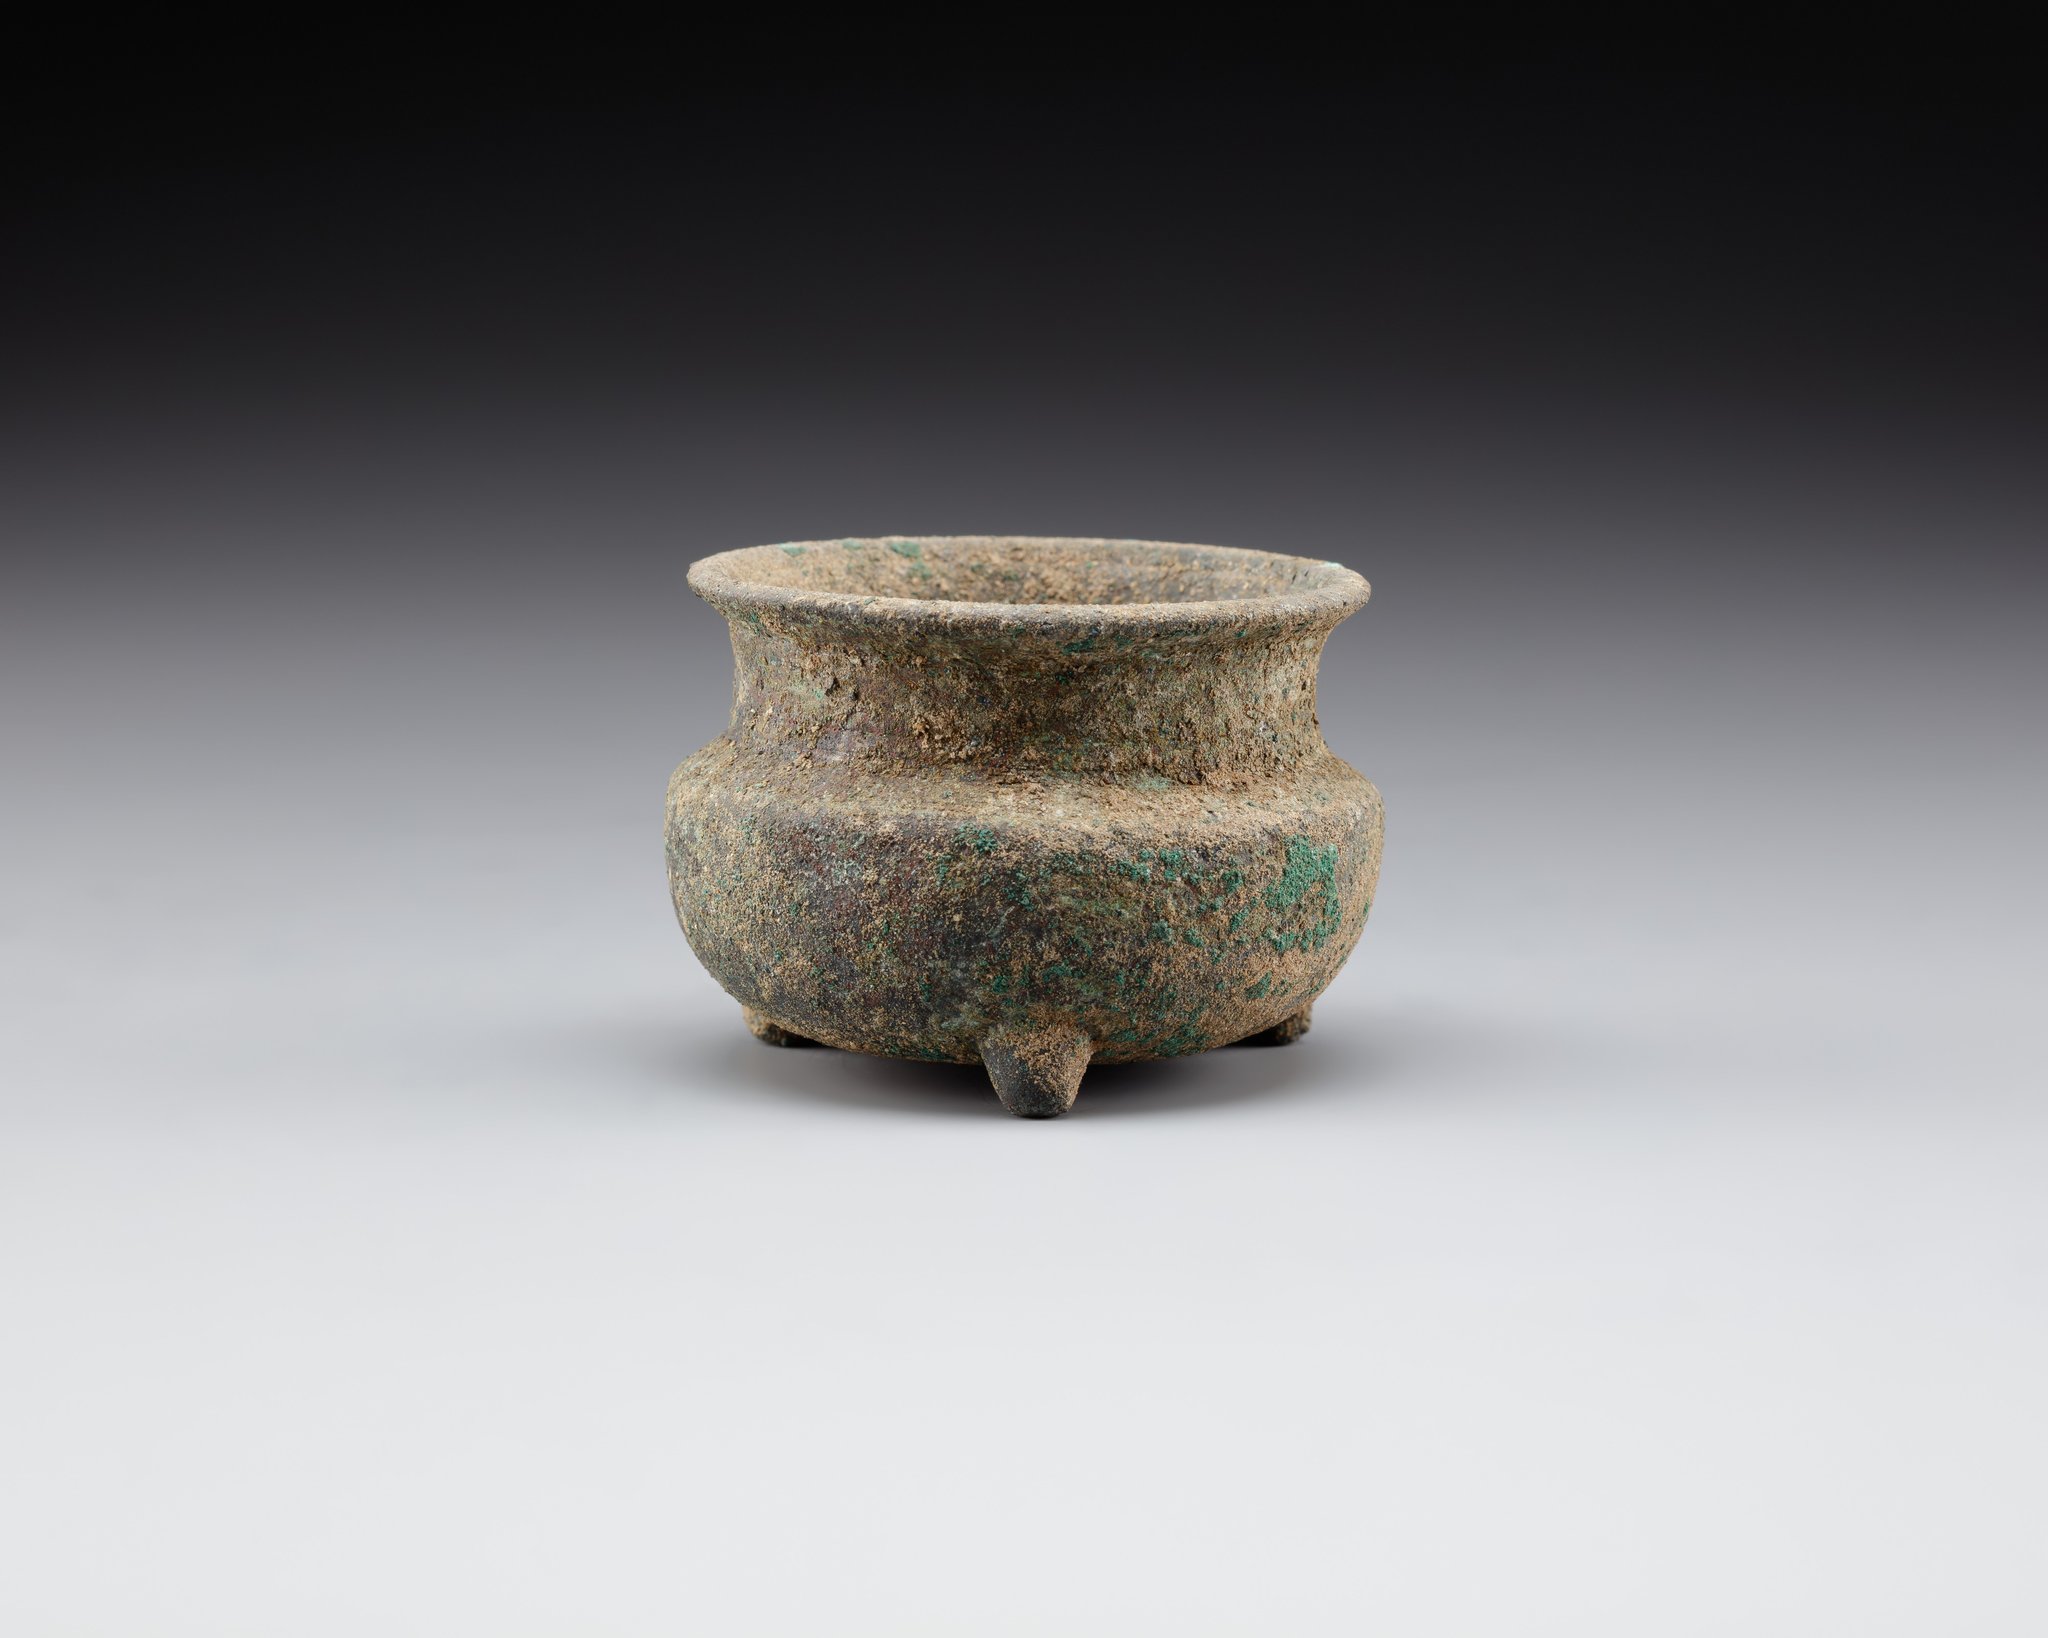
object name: bowl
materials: copper alloy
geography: nubia